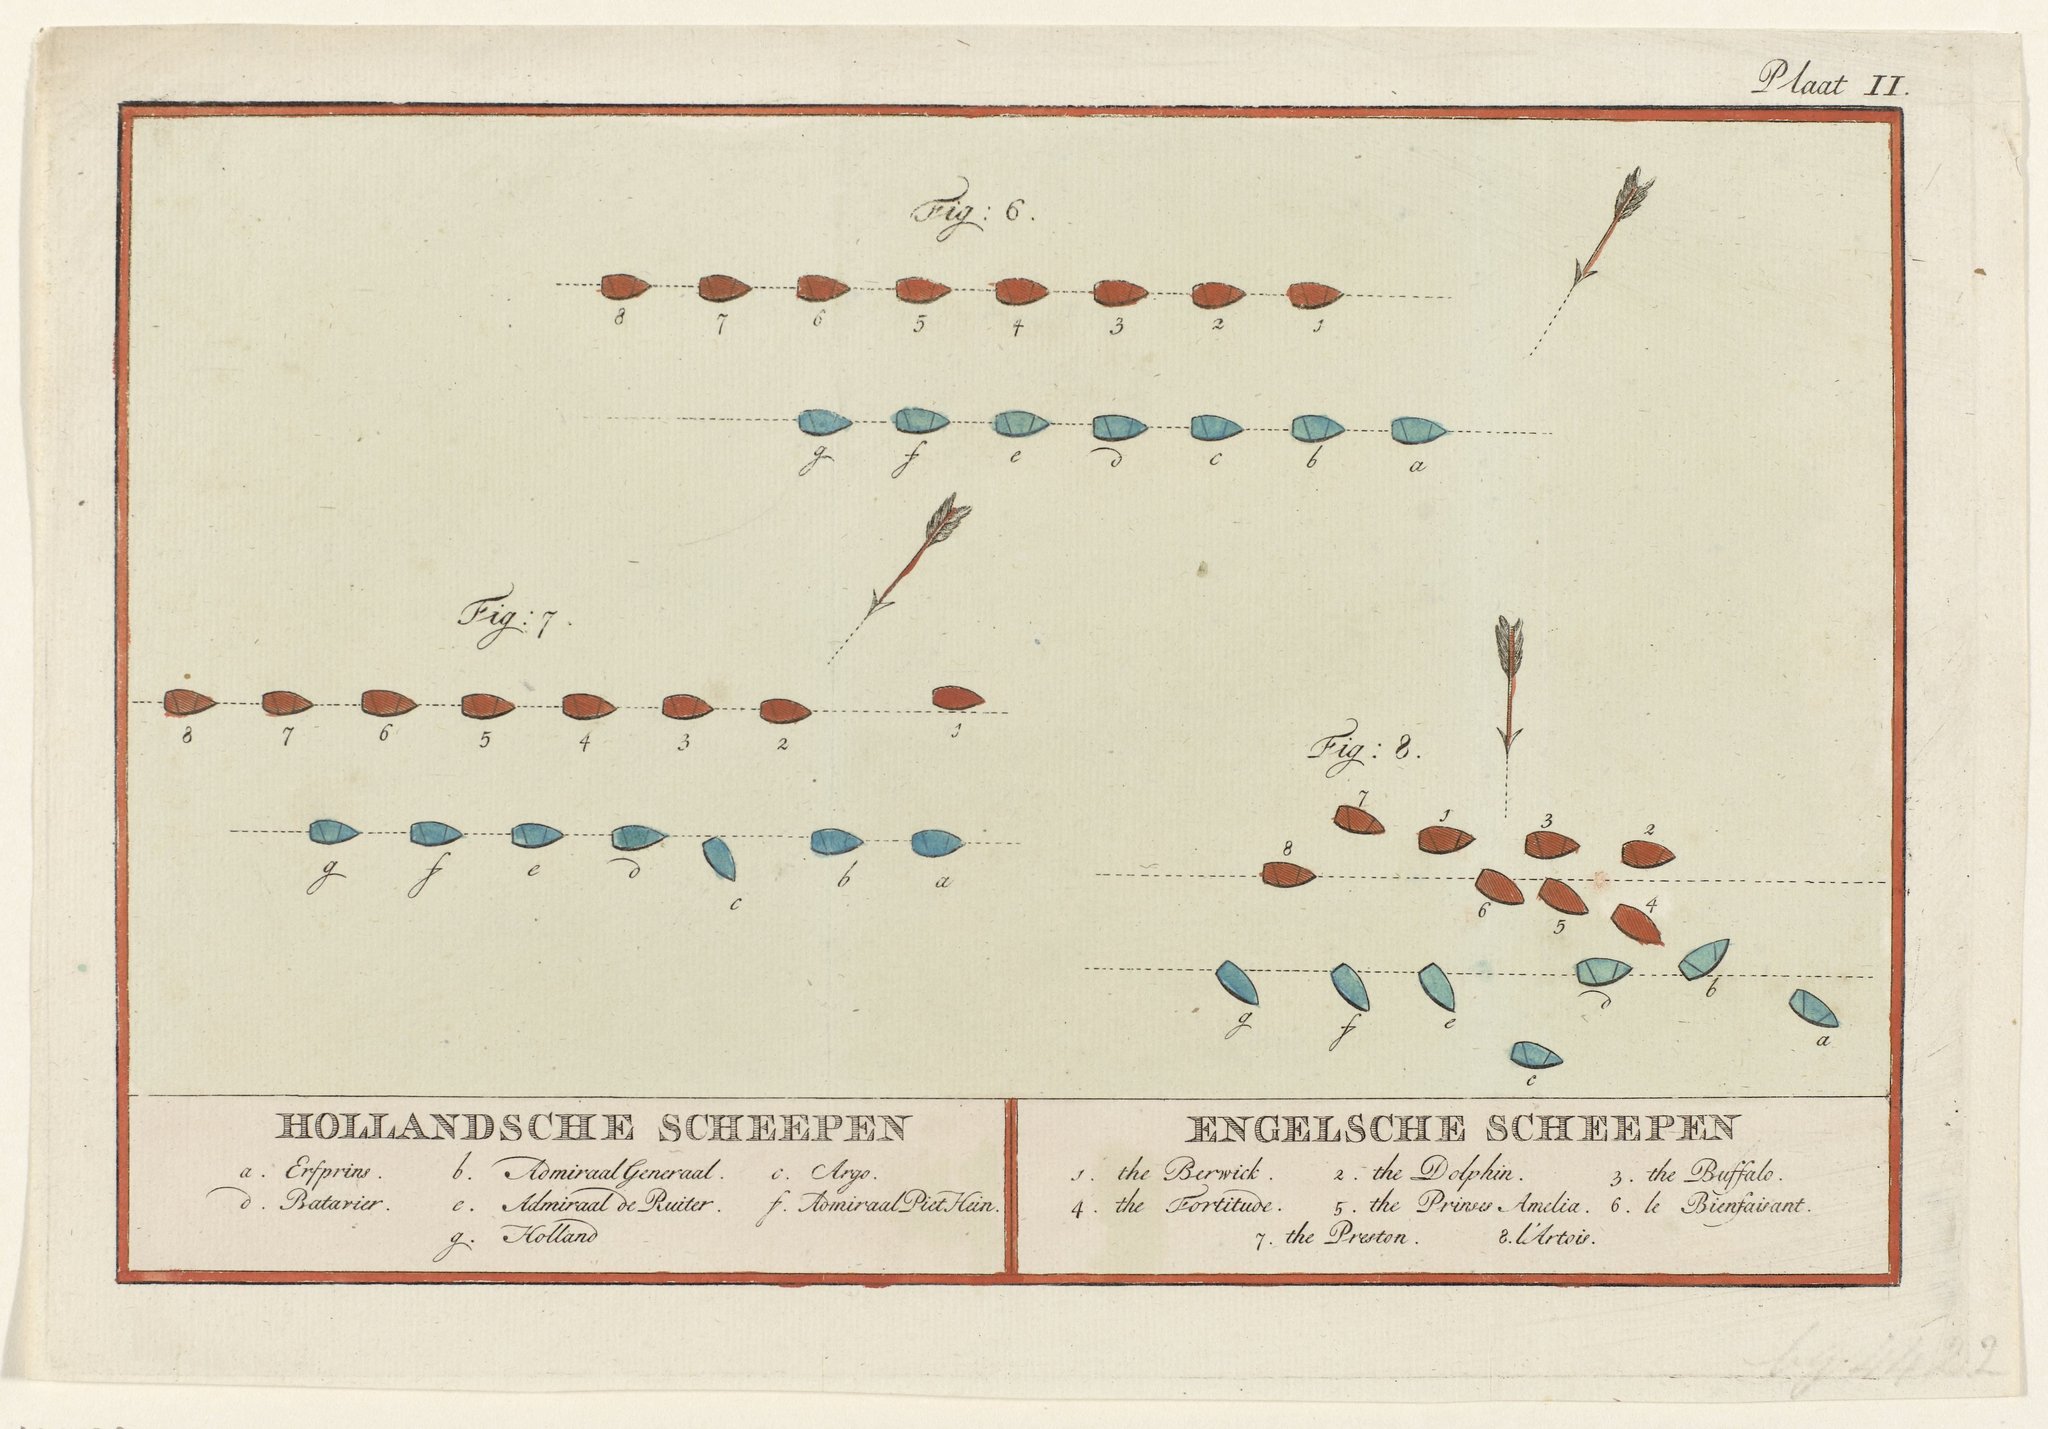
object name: print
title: Posities van de Nederlandse en Engelse schepen bij de zeeslag bij Doggersbank, 1781 (plaat II)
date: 1781-1783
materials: paper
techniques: engraving, etching, hand coloring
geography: northern netherlands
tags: the hague, johan arnold zoutman, hyde parker, battle arrays (+ sailing-ships)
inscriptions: collector's mark: Lugt 2228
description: Posities van de Nederlandse en Engelse schepen bij Doggersbank op 5 augustus 1781 tussen de Nederlandse vloot onder schout-bij-nacht Johan Zoutman en de Engelse vloot onder vice-admiraal Hyde Parker. Plaat II met de figuren 6-8. In het onderschrift de legenda met de namen van de betrokken oorlogsschepen.